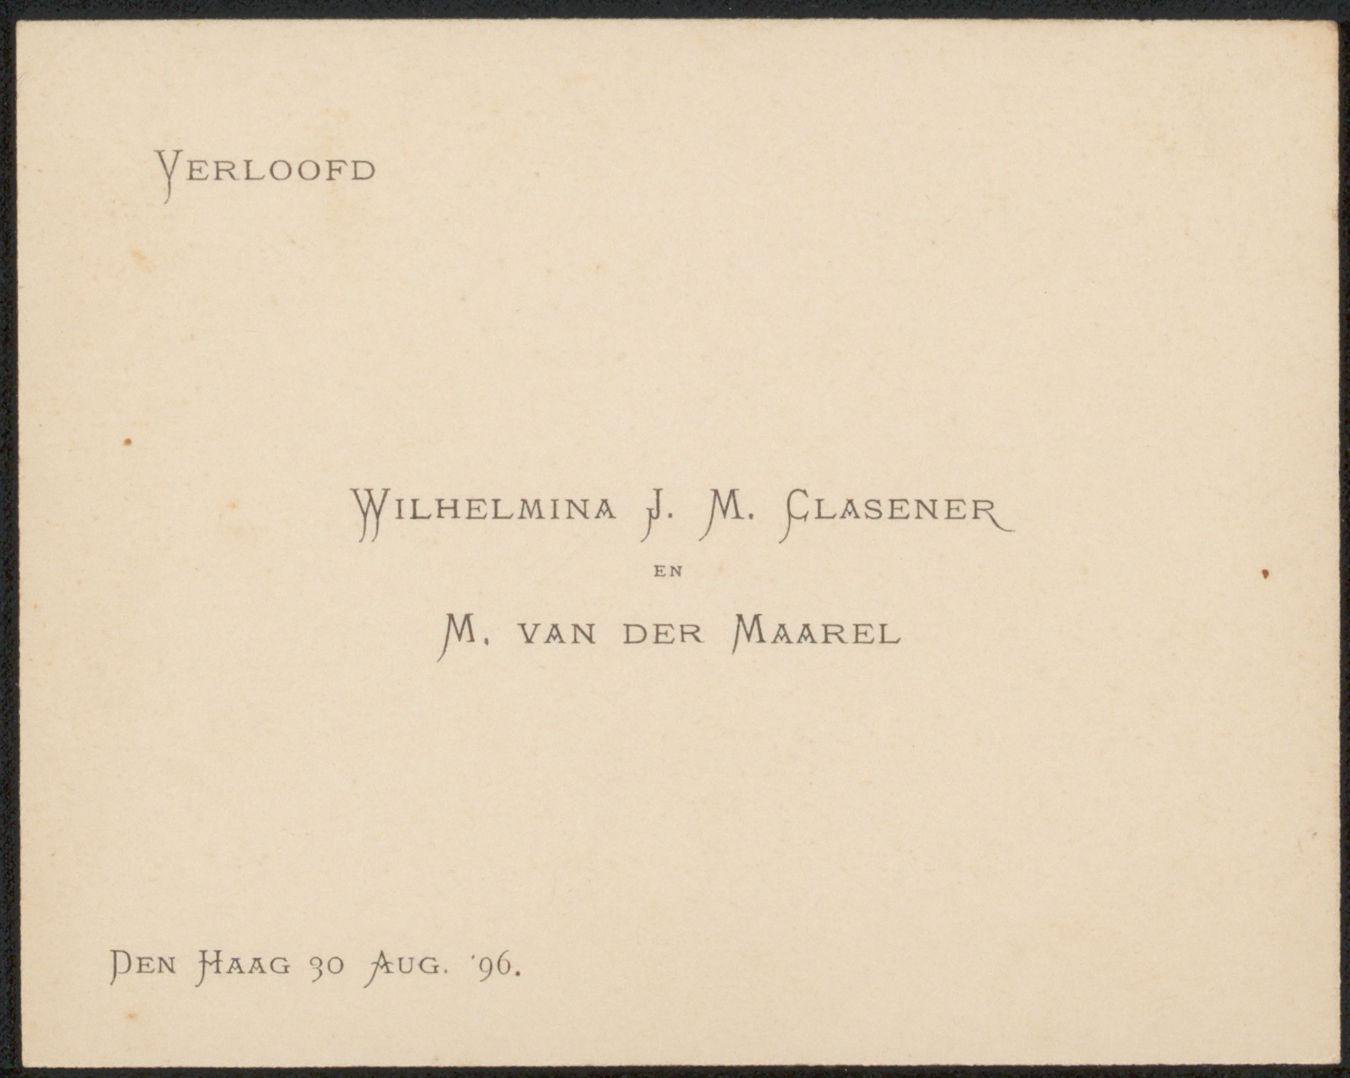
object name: wedding announcement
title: Verlovingsaankondiging aan Philip Zilcken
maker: Anonymous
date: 1896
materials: cardboard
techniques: printing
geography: the hague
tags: the hague, painter, draughtsman, marinus van der maarel, wilhelmina j.m. clasener-van der maarel, philip zilcken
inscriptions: collector's mark: ‘RPK’